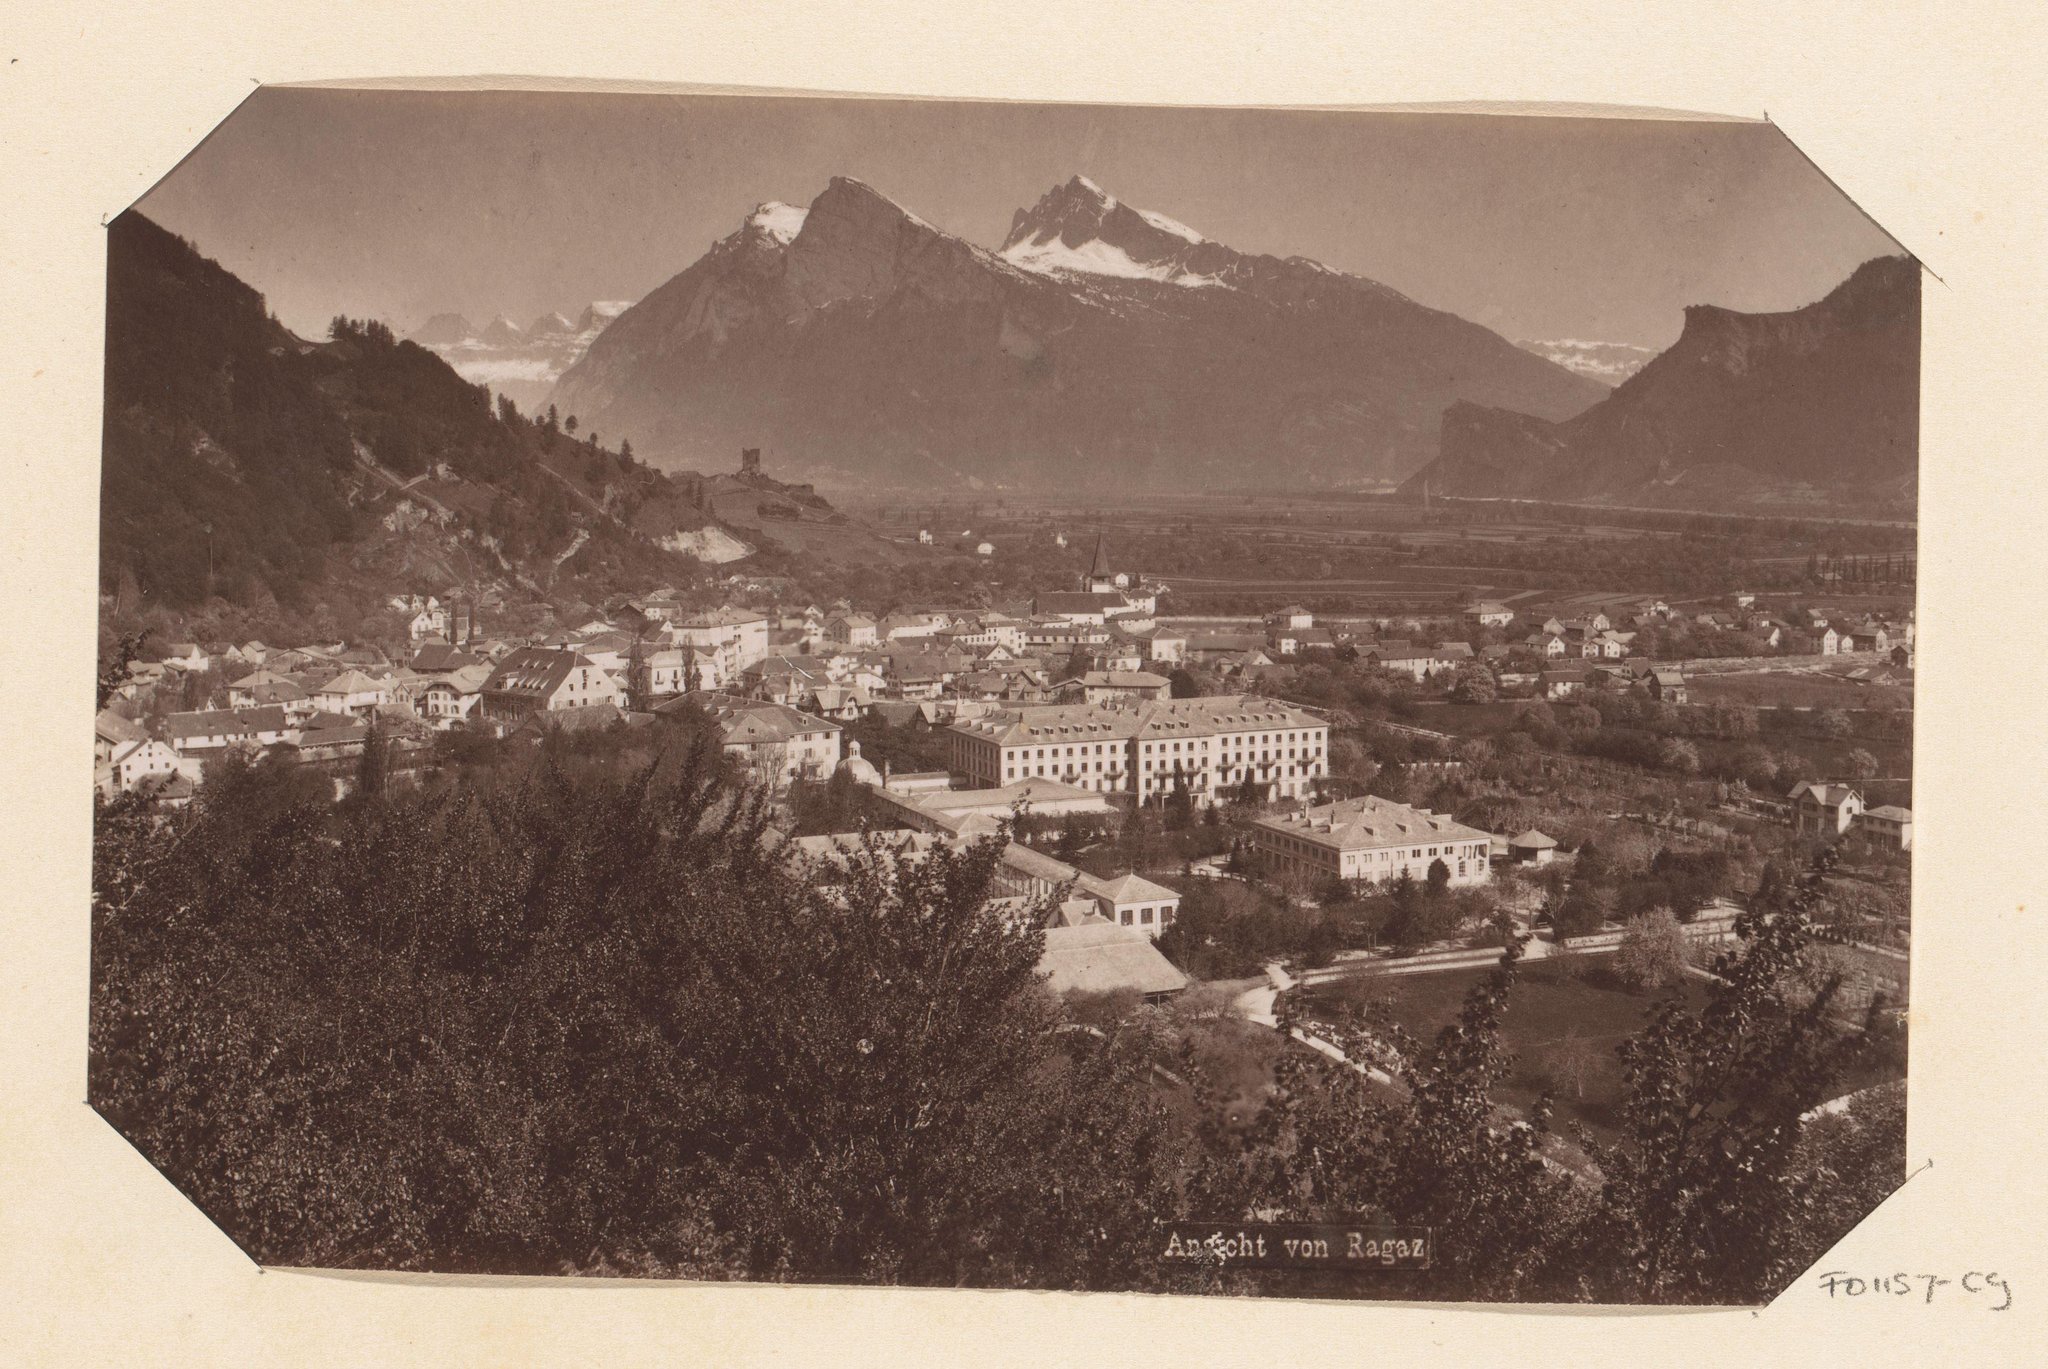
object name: photograph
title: Ansicht von Ragaz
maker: Anonymous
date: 1885-1892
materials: photographic support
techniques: albumen print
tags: city-view in general; 'veduta', mountains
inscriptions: annotation: ‘Ragatz - Panorama’